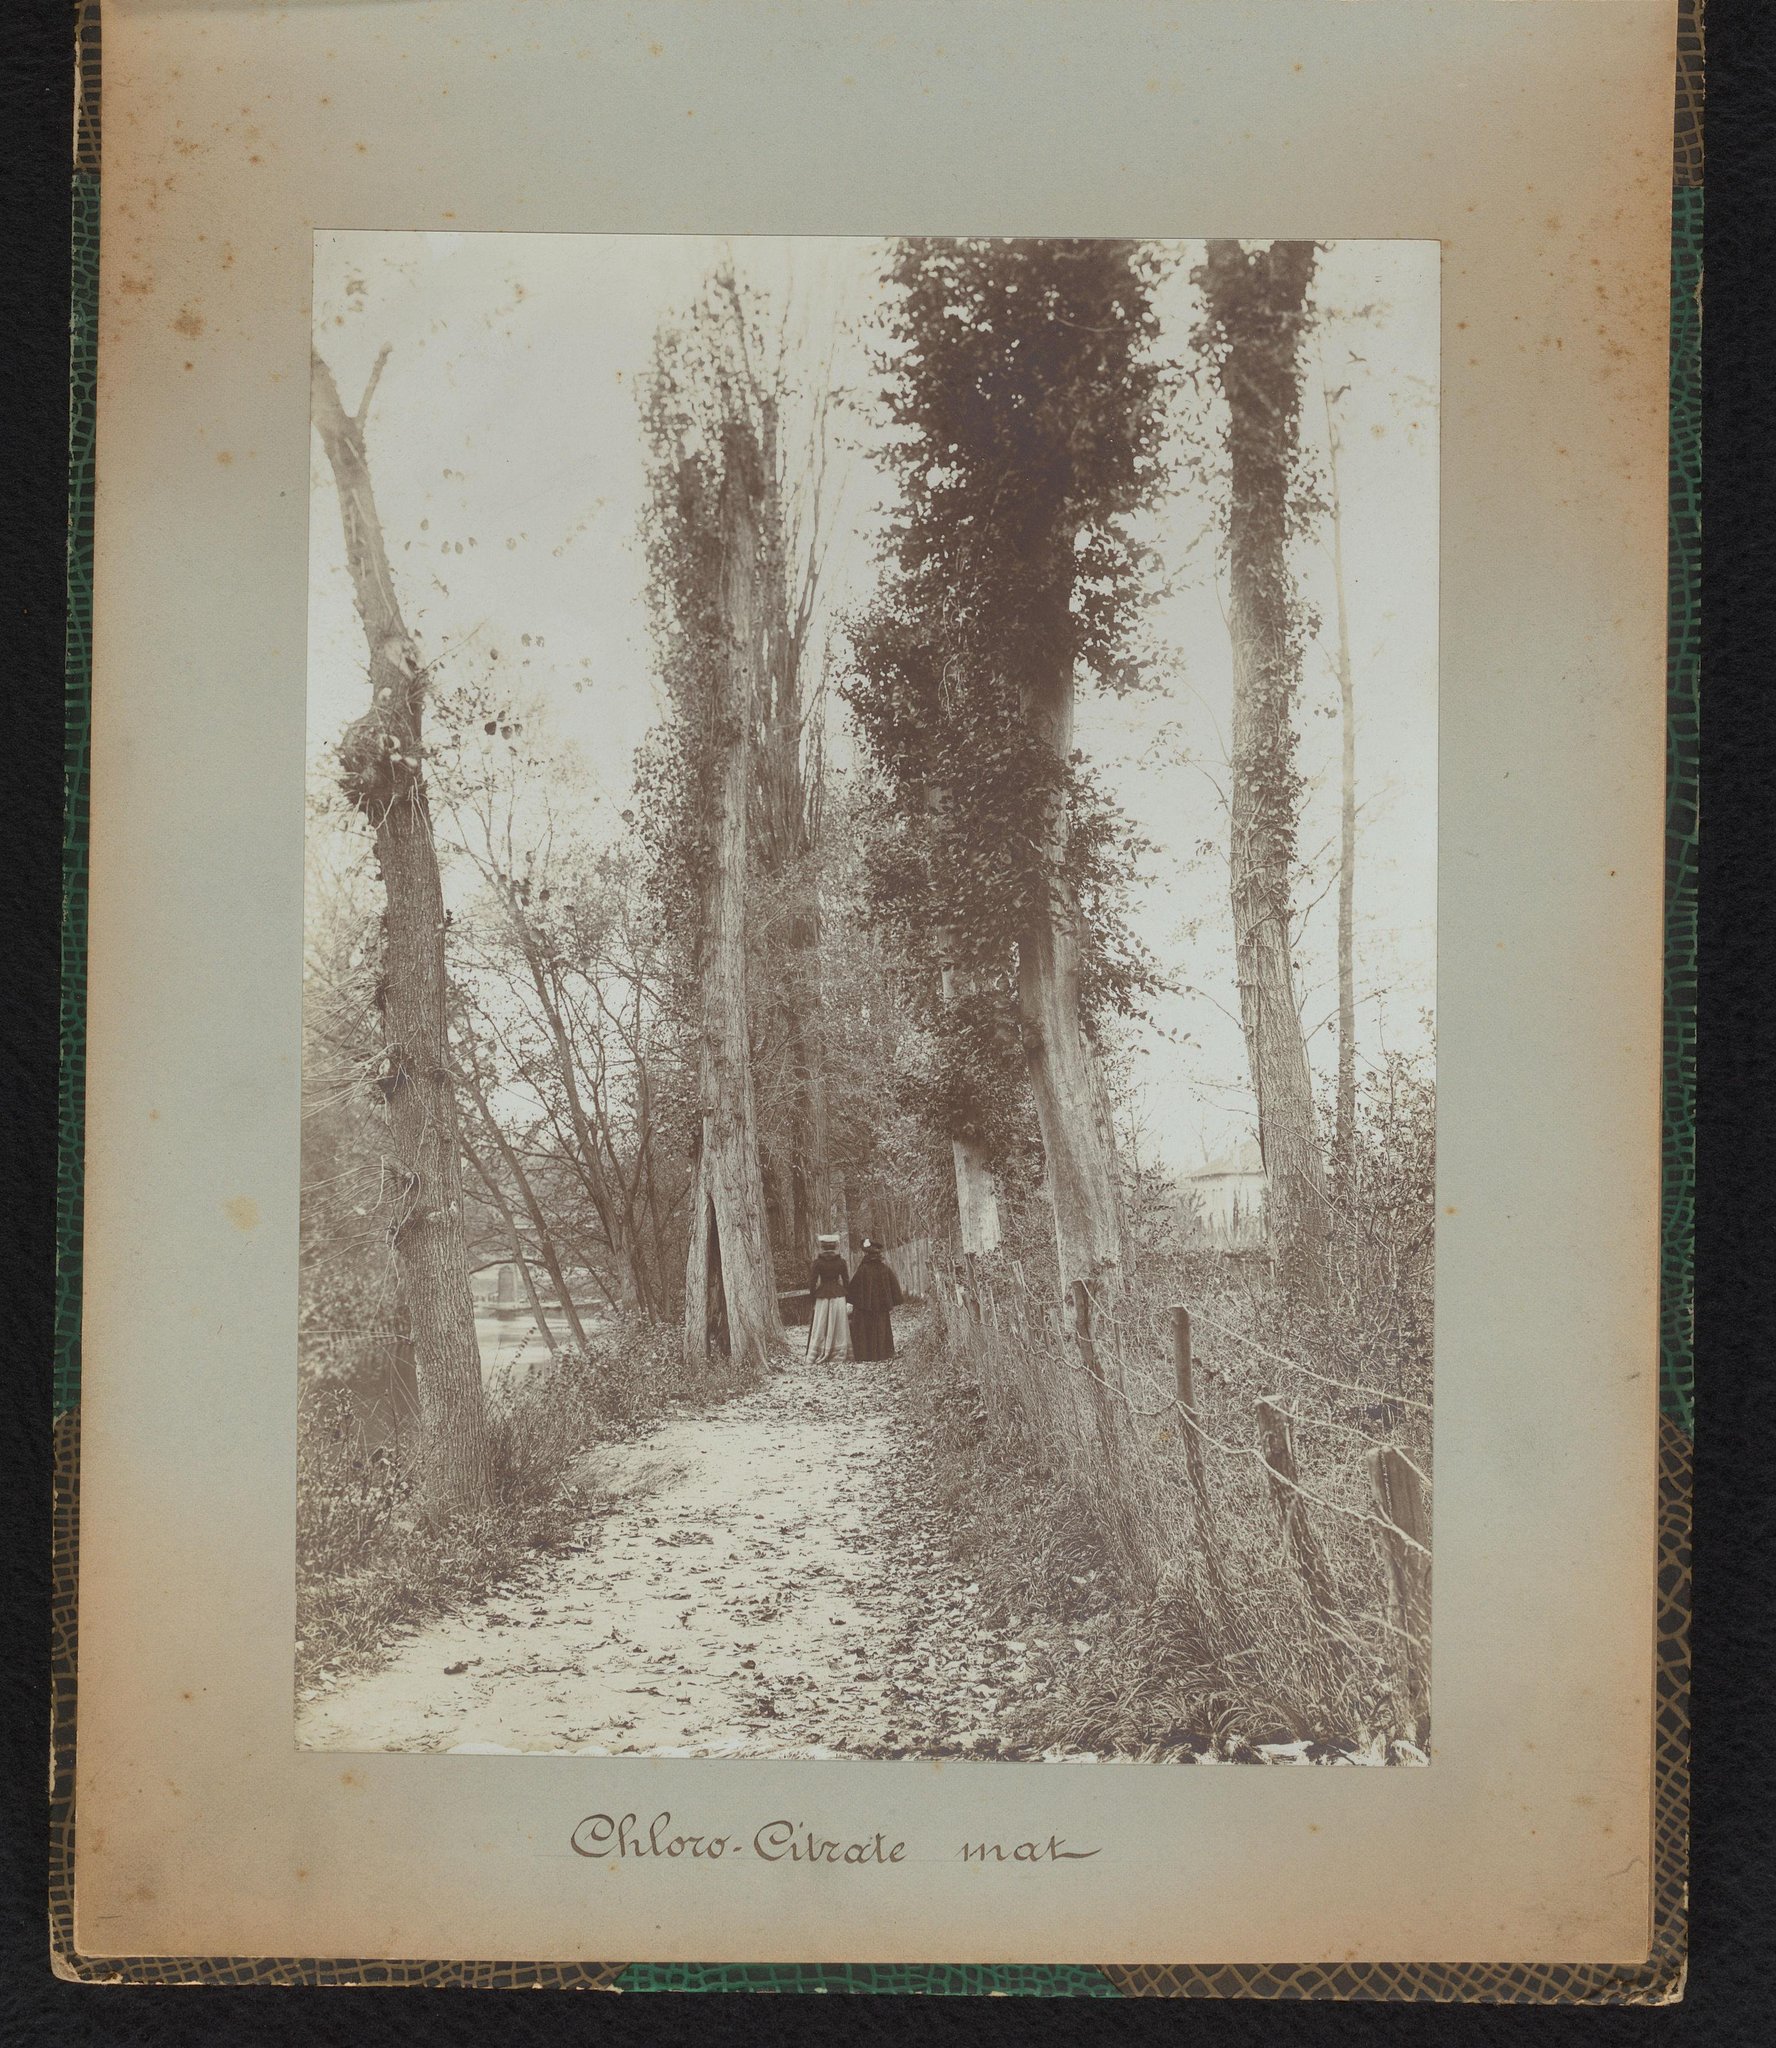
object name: photograph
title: Twee vrouwen, van achteren gezien, op een bospad met hek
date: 1890-1910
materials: paper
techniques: daylight paper print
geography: paris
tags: historical persons not known by name - bb - woman, fence, wall, paling, forest path or lane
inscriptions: inscription: ‘Chloro-Citrate mat’